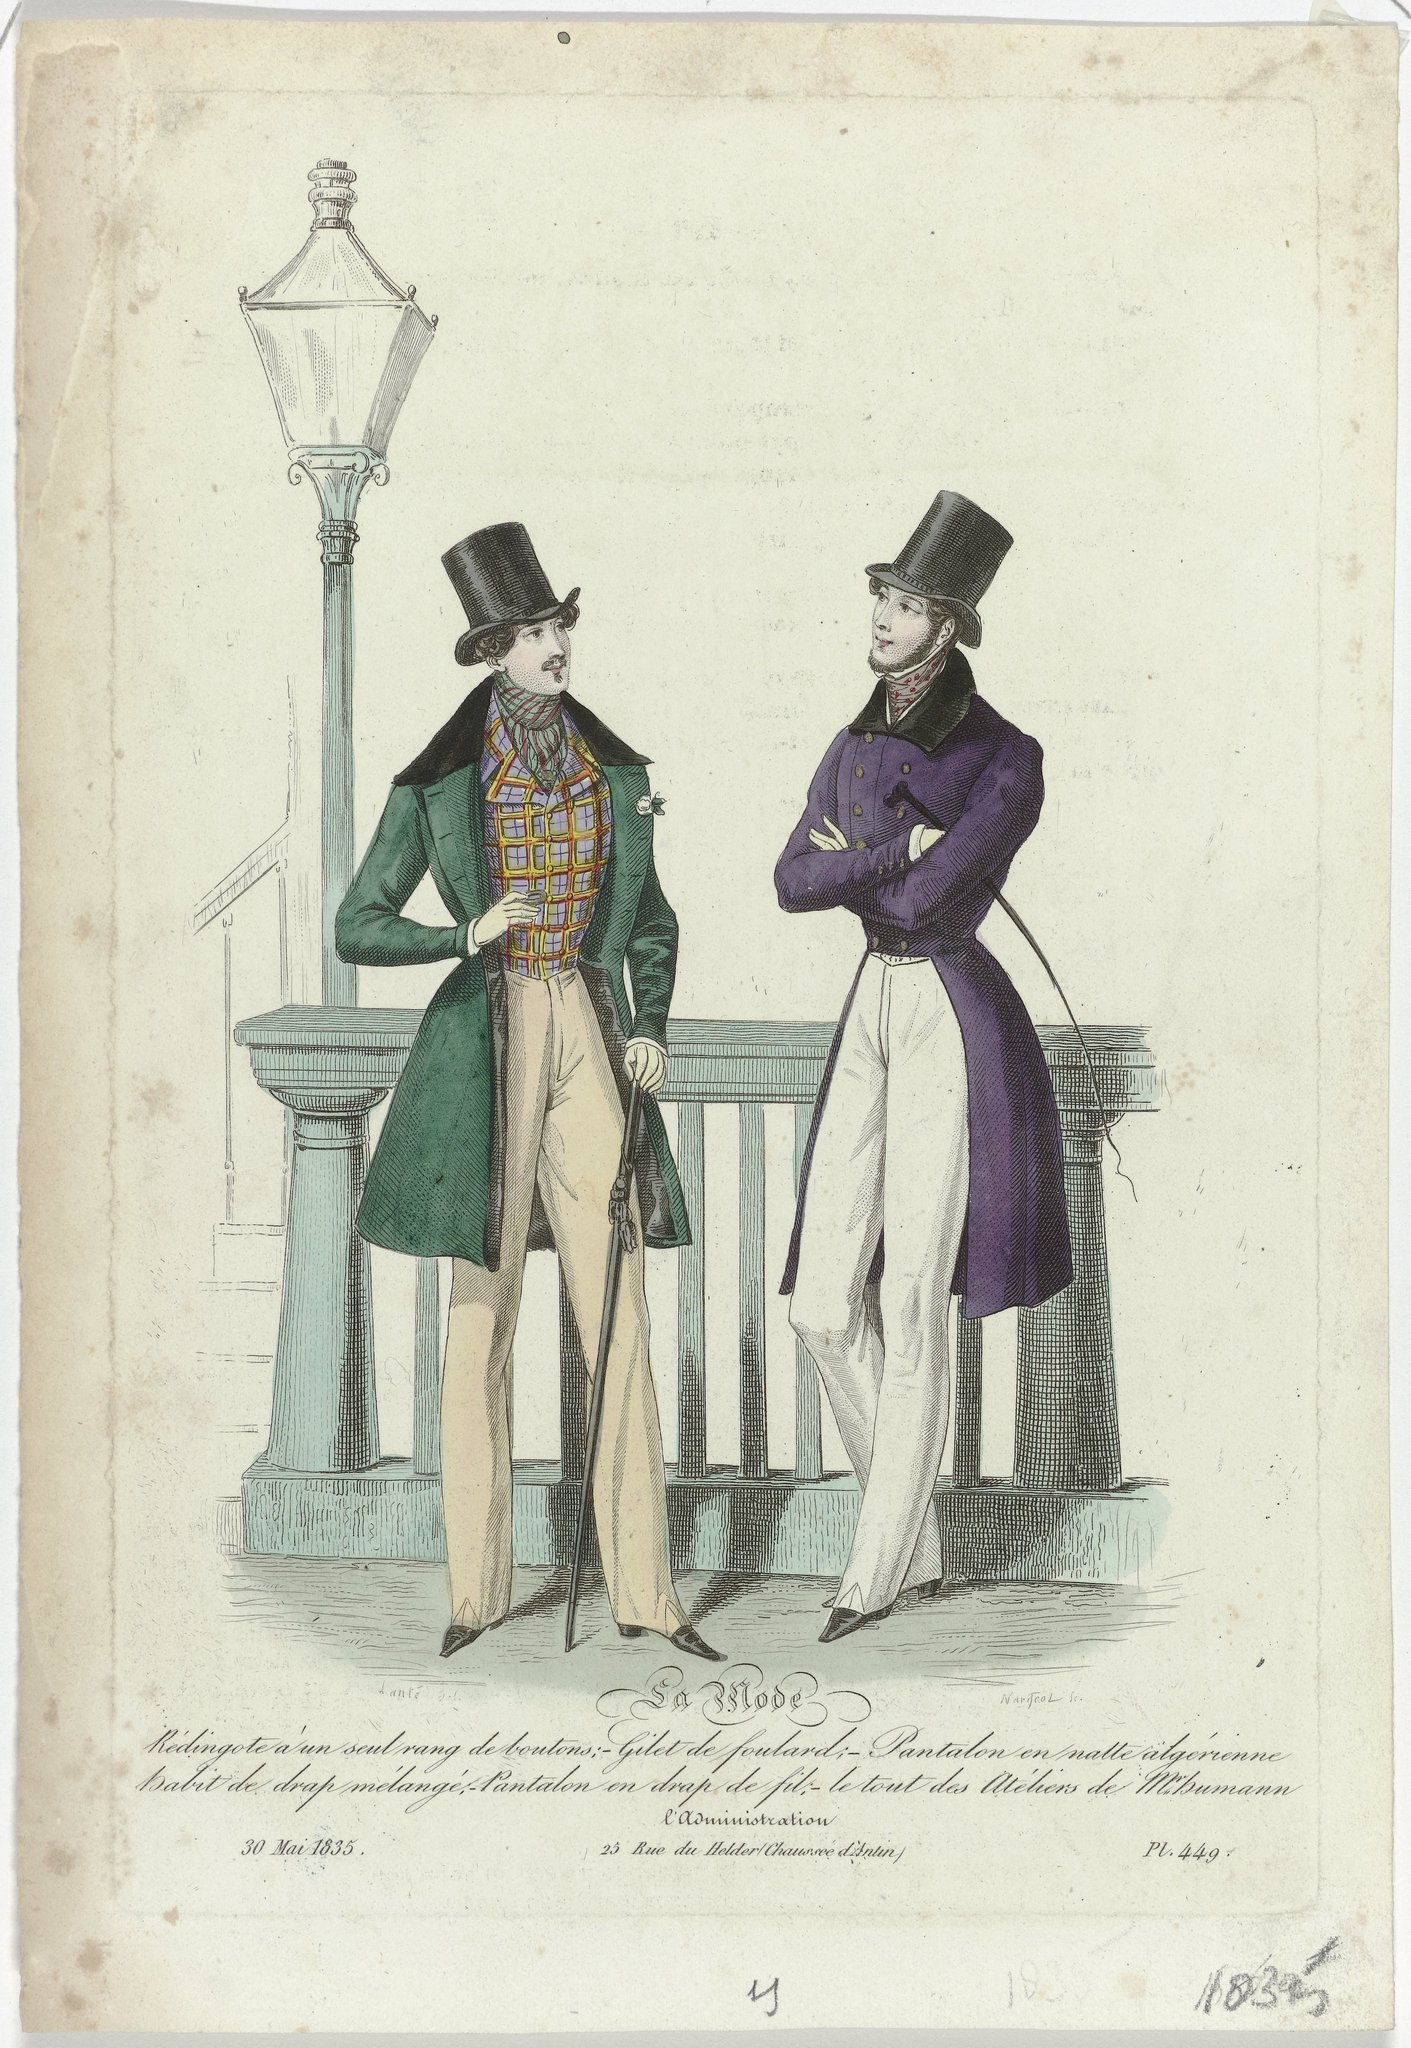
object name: fashion print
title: La Mode, 30 mai 1835, Pl. 449 : Rédingote à un seul rang (...)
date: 1835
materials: paper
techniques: hand coloring, engraving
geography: paris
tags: clothing for the upper part of the body (vest) (+ men's clothes), neck-gear ~ clothing (+ men's clothes), trousers, breeches, etc. (pantalon) (+ men's clothes), coat (+ men's clothes), fashion plates, shoes, sandals (+ men's clothes), gloves, mittens, etc. (+ men's clothes), walking-stick, staff, cane (+ men's clothes), whip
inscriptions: caption: ‘Redingote à un seul rang de boutons; - Gilet de foulard; - Pantalon en natte algérienne Habit de drap mélangé; - Pantalon en drap de fil; - le tout des Atéliers de M"r Humann’, address: ‘L'Administration / 25 Rue du Helder ( Chaussée d'Antin )’, title: ‘La Mode.’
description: Redingote met een enkele rij knopen. Vest van foulard. Lange broek van 'natte algérienne'. 'Habit' van gemêleerd (?) laken. Lange broek van 'drap de fil'. Alles uit de ateliers van Mr Humann. Accessoires: hoge hoed, geknoopte halsdoek, handschoenen, zweep, wandelstok, schoenen met hakken. Prent uit het modetijdschrift La Mode (1829-1855).